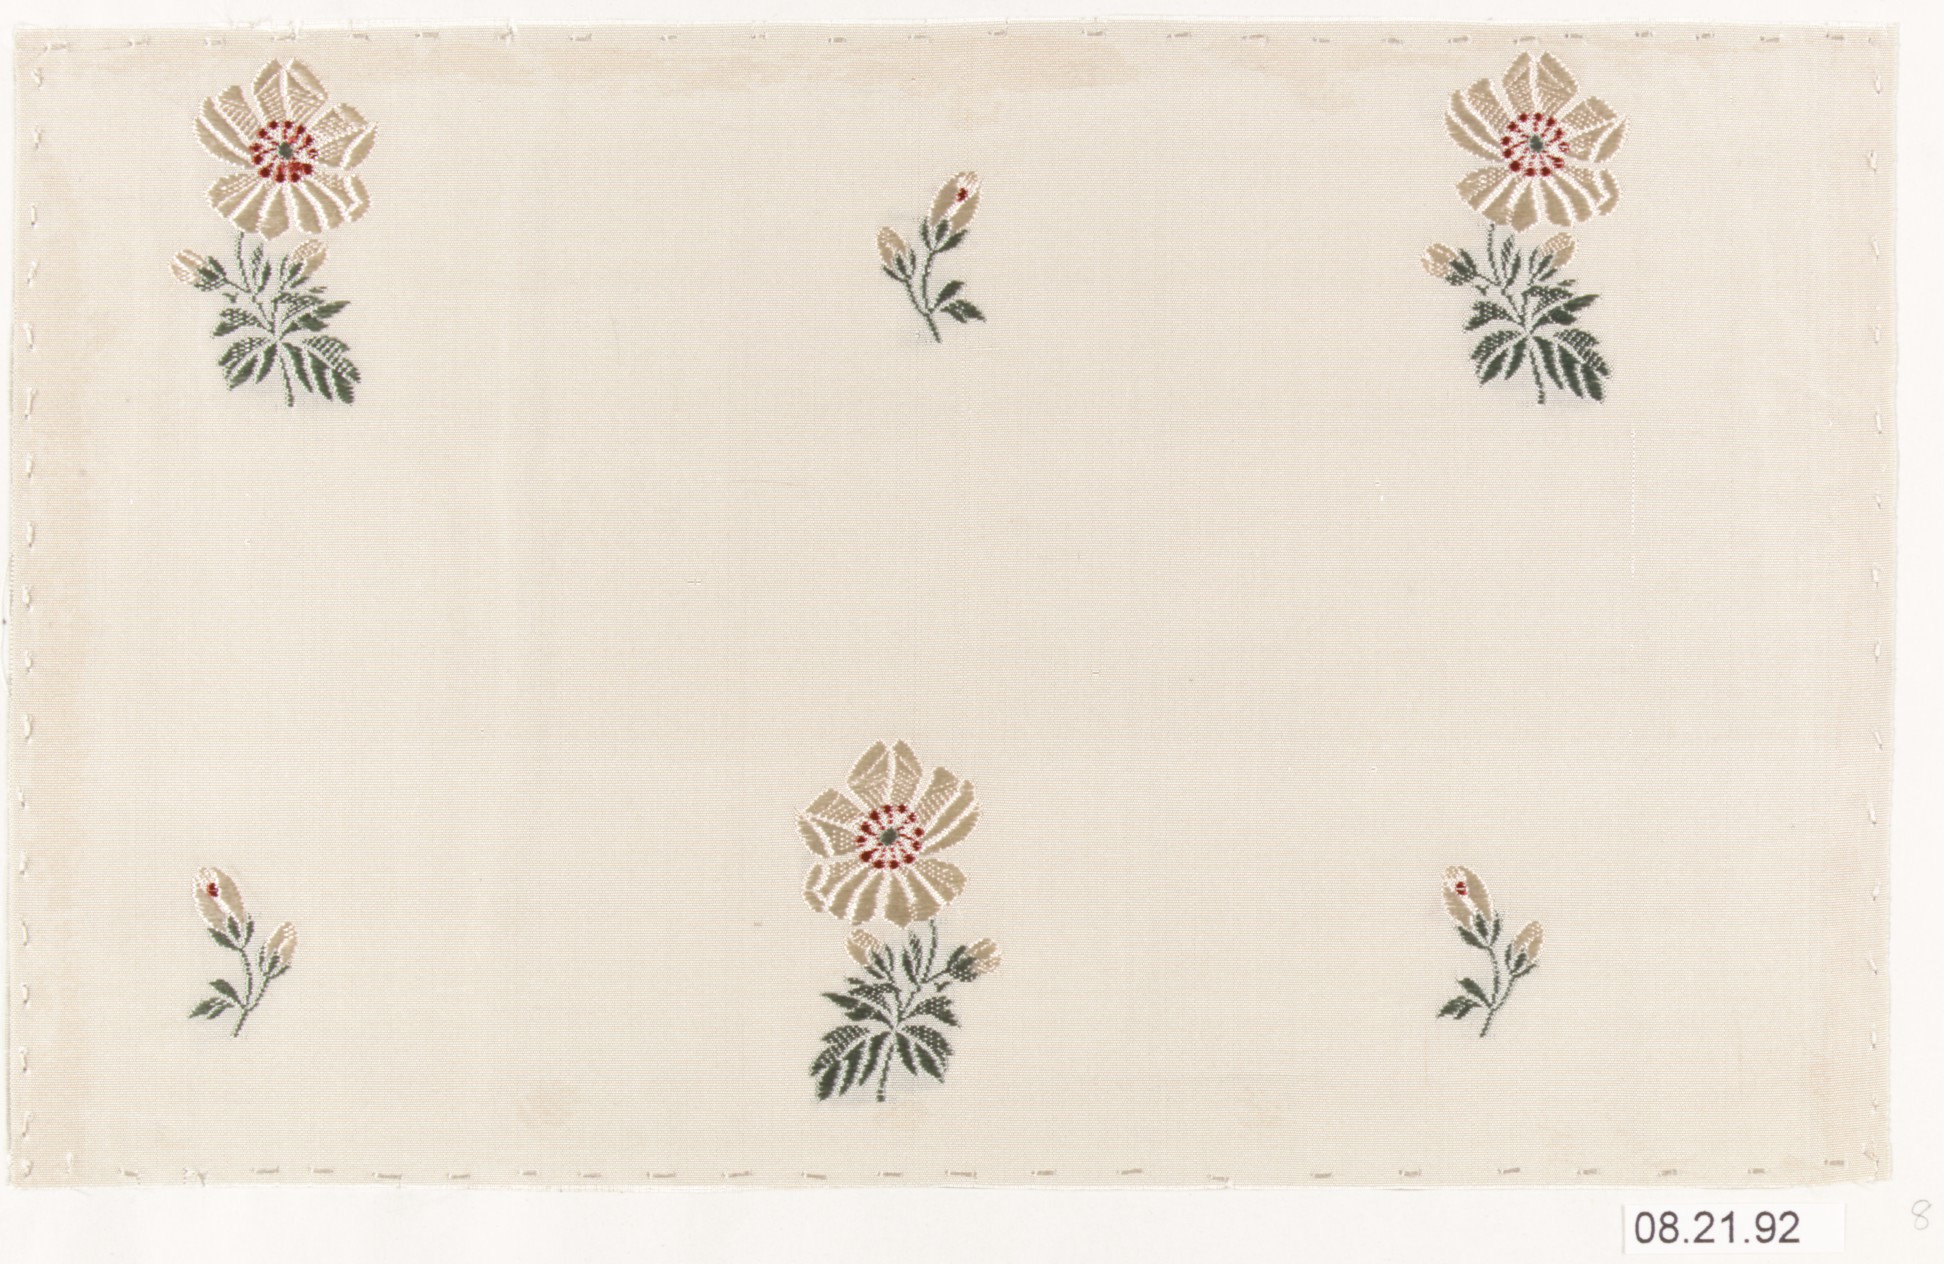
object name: textile sample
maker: Anonymous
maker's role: designer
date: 1900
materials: silk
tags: flowers